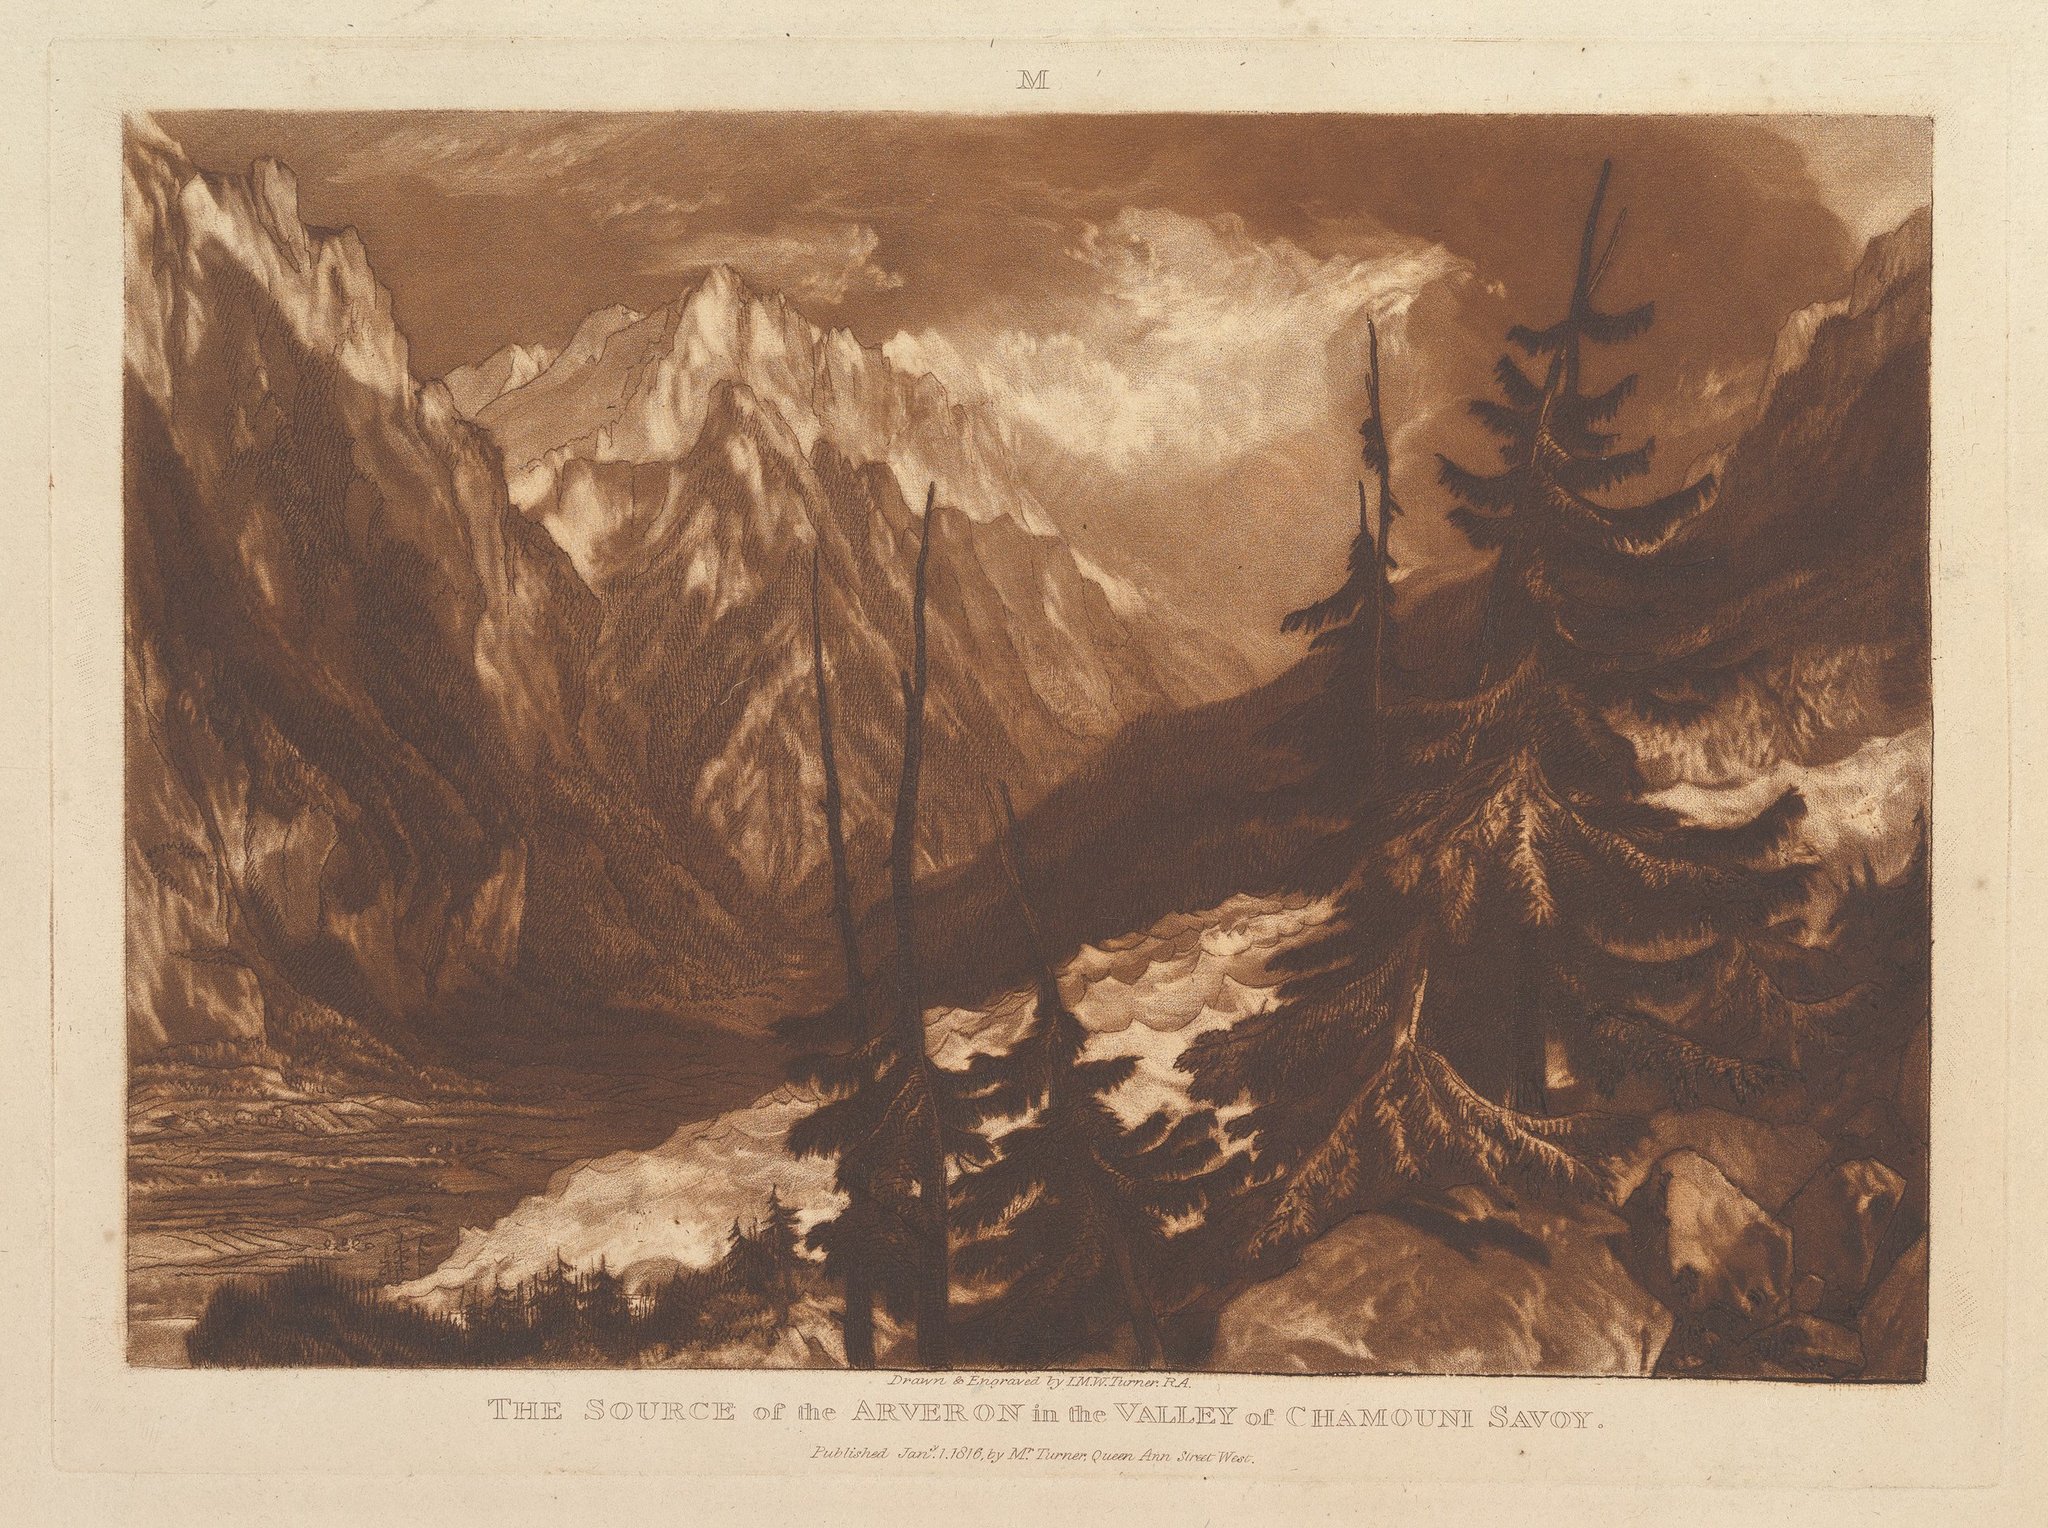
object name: print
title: The Source of the Arvaron in the Valley of Chamouni, Savoy, part XII, plate 60 from "Liber Studiorum"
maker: joseph mallord william turner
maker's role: artist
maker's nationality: british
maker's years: 1775-1851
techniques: etching, mezzotint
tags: mountains,trees,snow